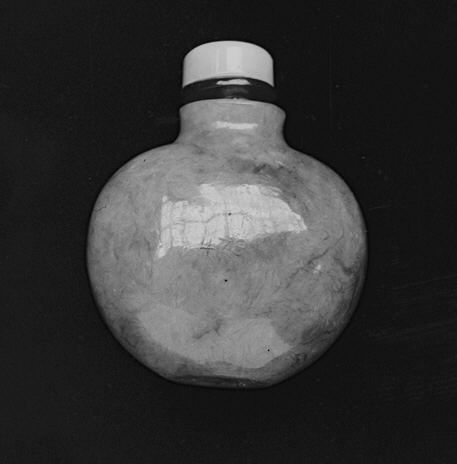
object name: snuff bottle with stopper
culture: chinese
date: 1736-1795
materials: gemstone, jade